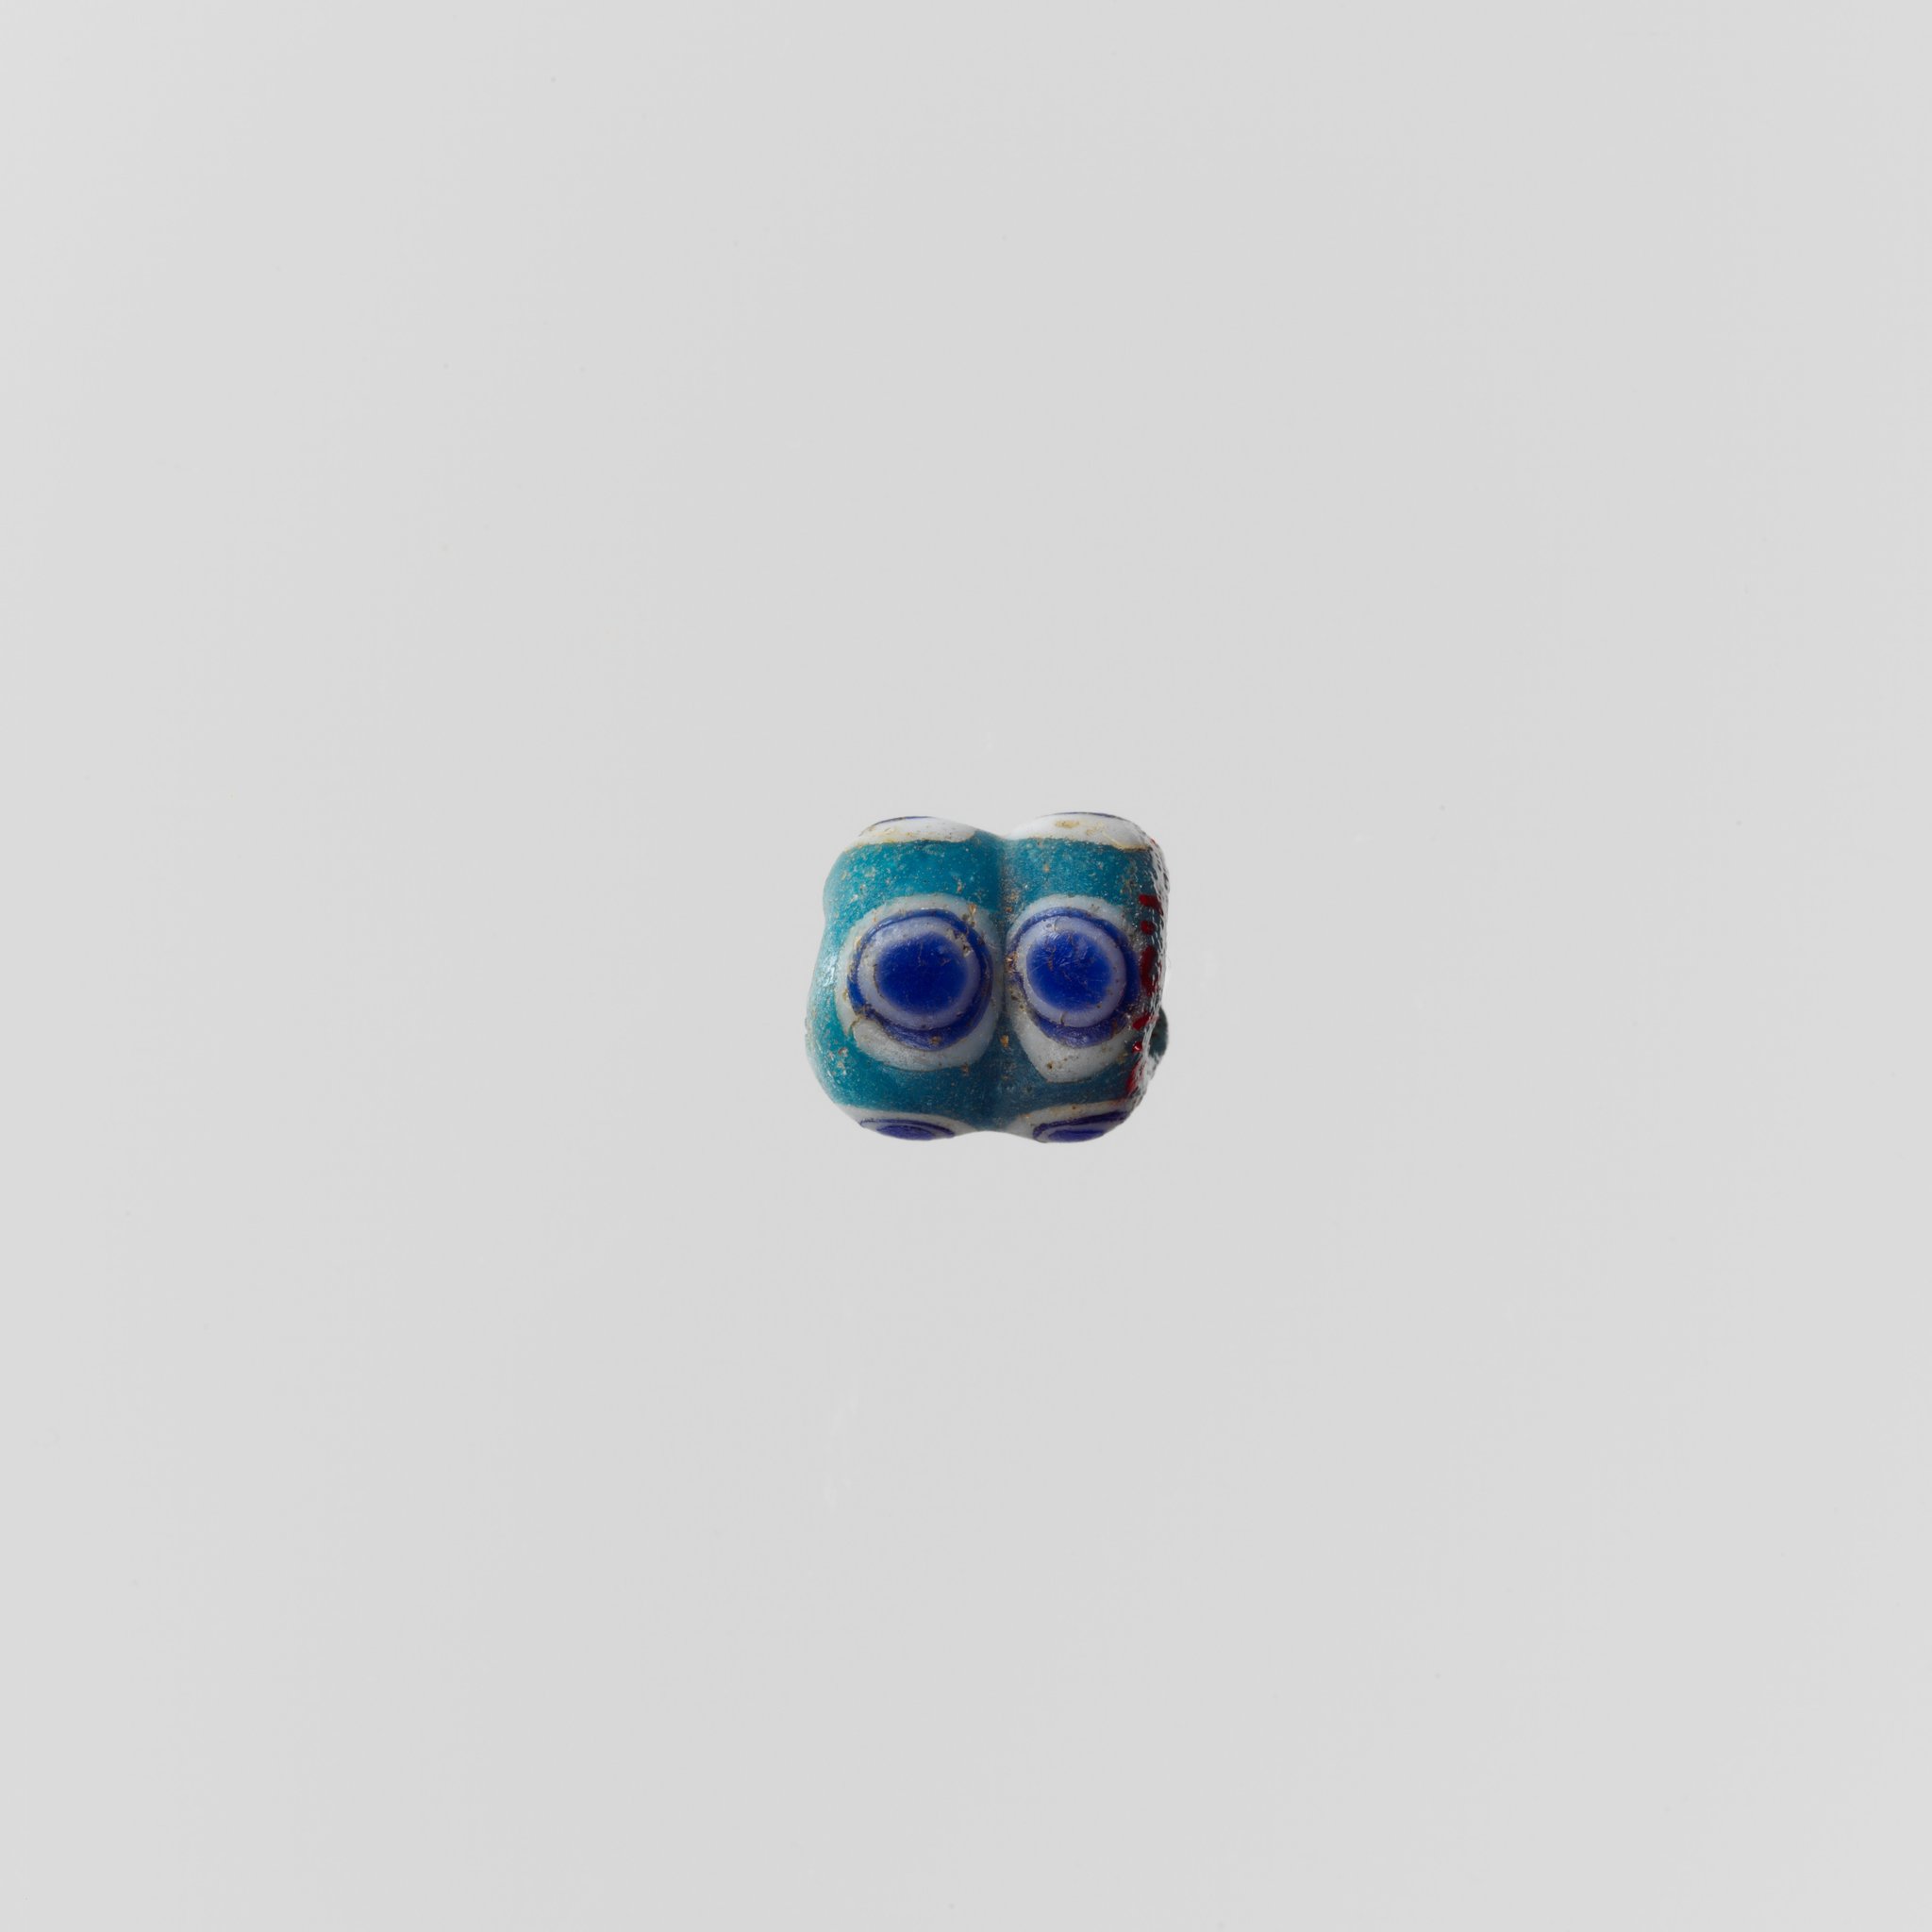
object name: bead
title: Glass eye bead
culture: phoenician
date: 600-301 BCE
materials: glass